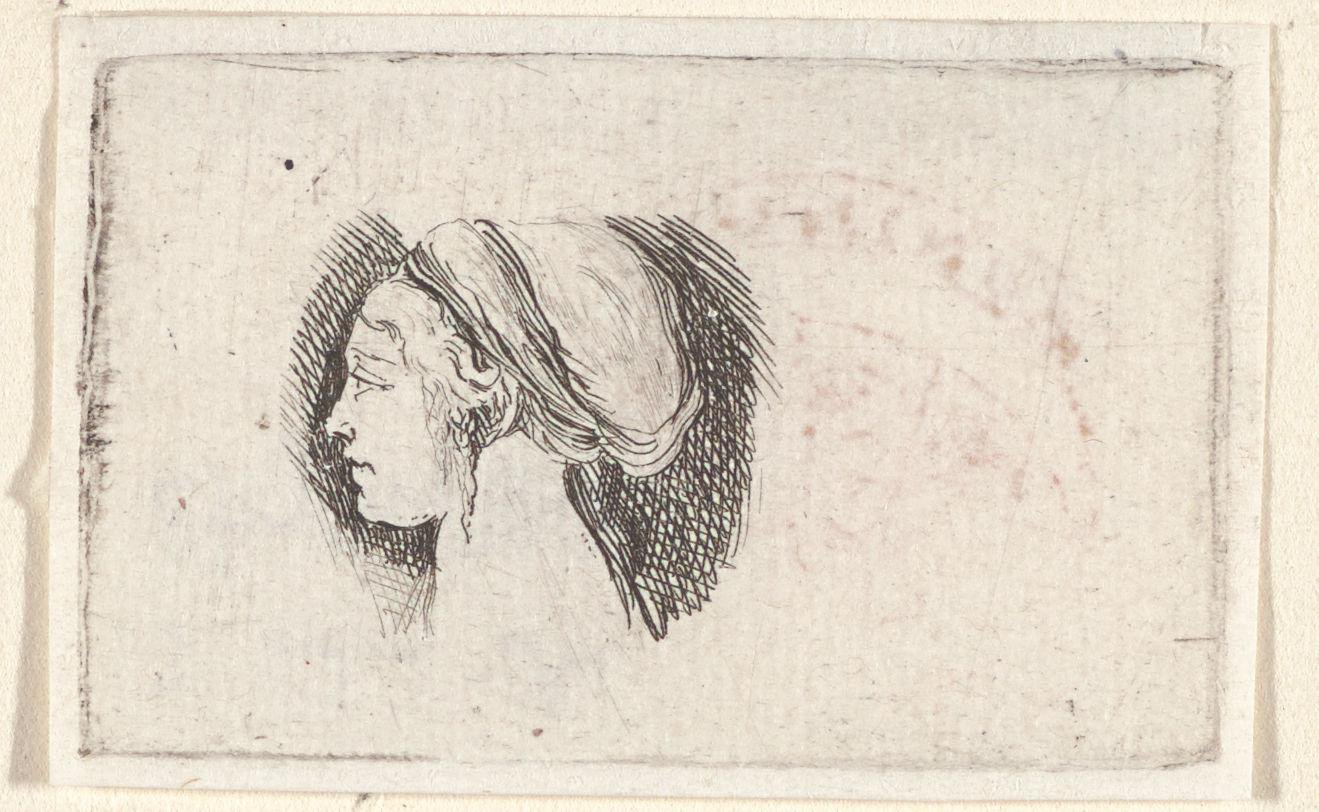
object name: print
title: Recueil de divers griffonnemens et preuves d'eau forte [deel 2]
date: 1620-1664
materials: paper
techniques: etching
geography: france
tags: adult woman, head (human) (+ sideview, profile)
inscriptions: collector's mark: Lugt 240